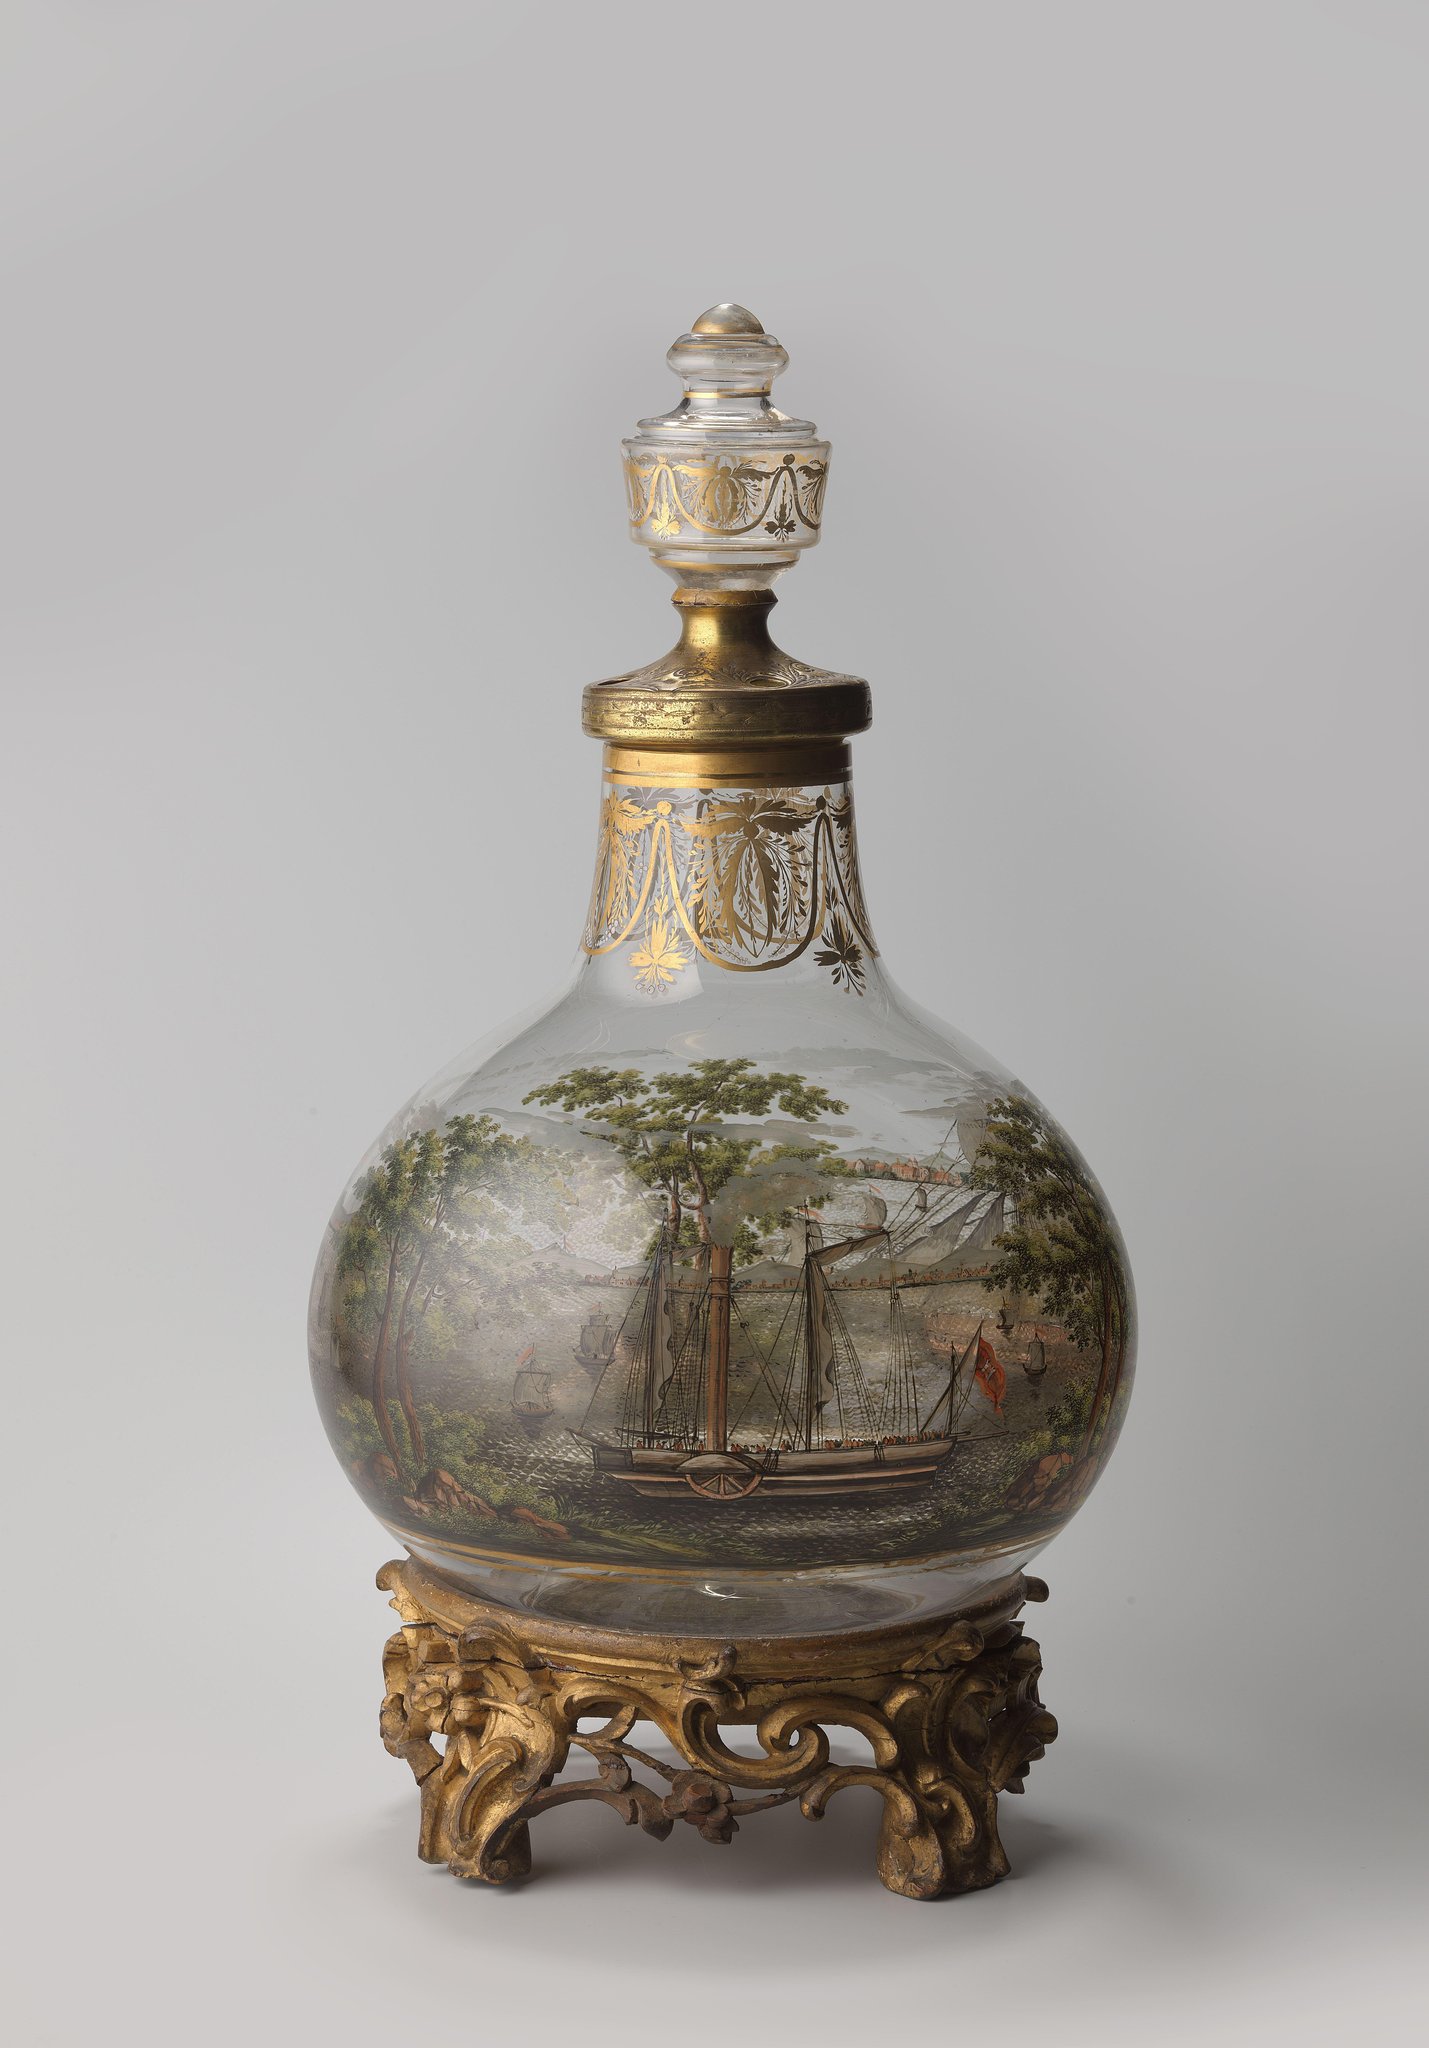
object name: goudviskom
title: Goudviskom met drie schepen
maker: Anonymous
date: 1825-1850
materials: glass, metal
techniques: gilding, glassblowing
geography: bohemia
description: Vlakke bodem, bolvormig lichaam, overgaande in een korte hals. . De kom beschilderd met een raderboot en twee oorlogsschepen in een baai; op de voorgrond rotspartijen en boomgroepen, op de achtergrond een heuvelachtige kust met huizen. Langs de bovenrand een guirlande in wit en goud. Gemaakt voor de Nederlandse markt.